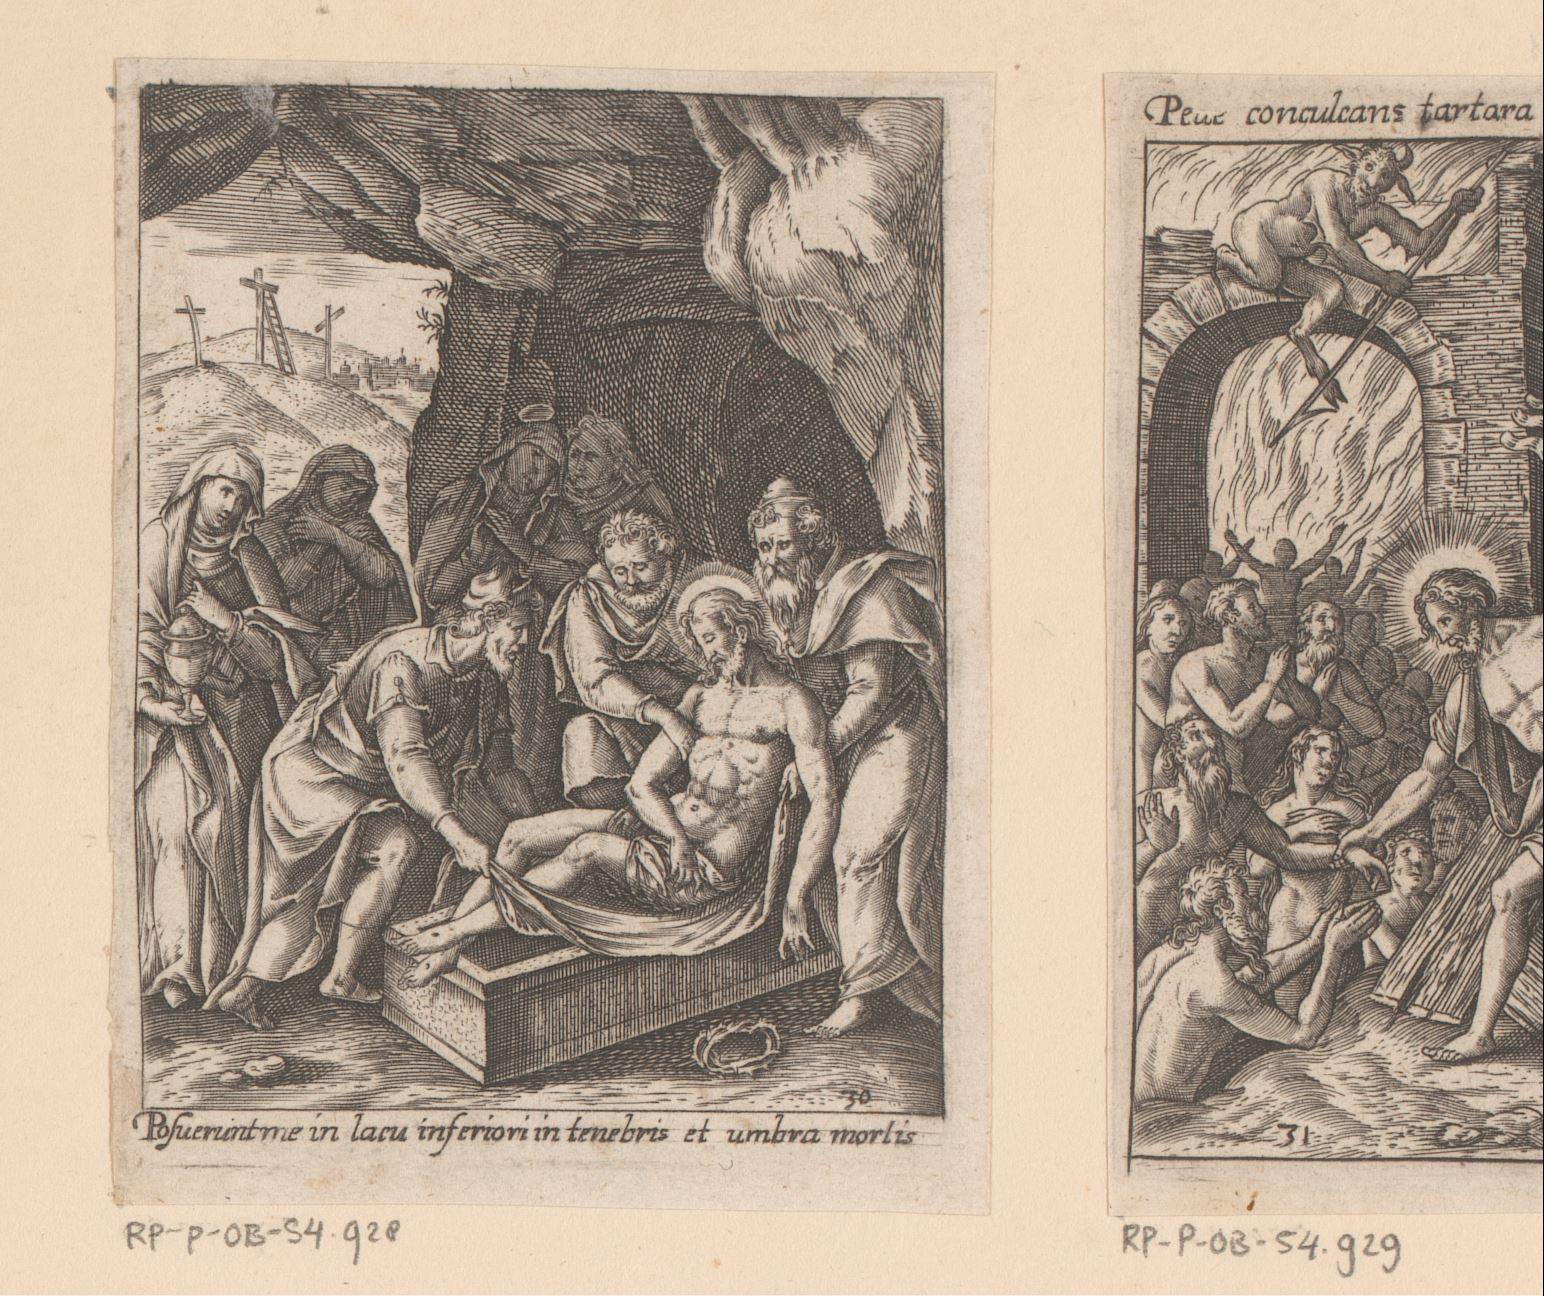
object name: print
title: Vita, passio et resurrectio Jesu Christi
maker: heinrich ulrich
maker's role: draughtsman, painter, print maker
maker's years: 1572-1671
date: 1582-1671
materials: paper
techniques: engraving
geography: germany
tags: christ's entombment (possibly by angels)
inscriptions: number: ‘38. - 64.’, collector's mark: Lugt 240